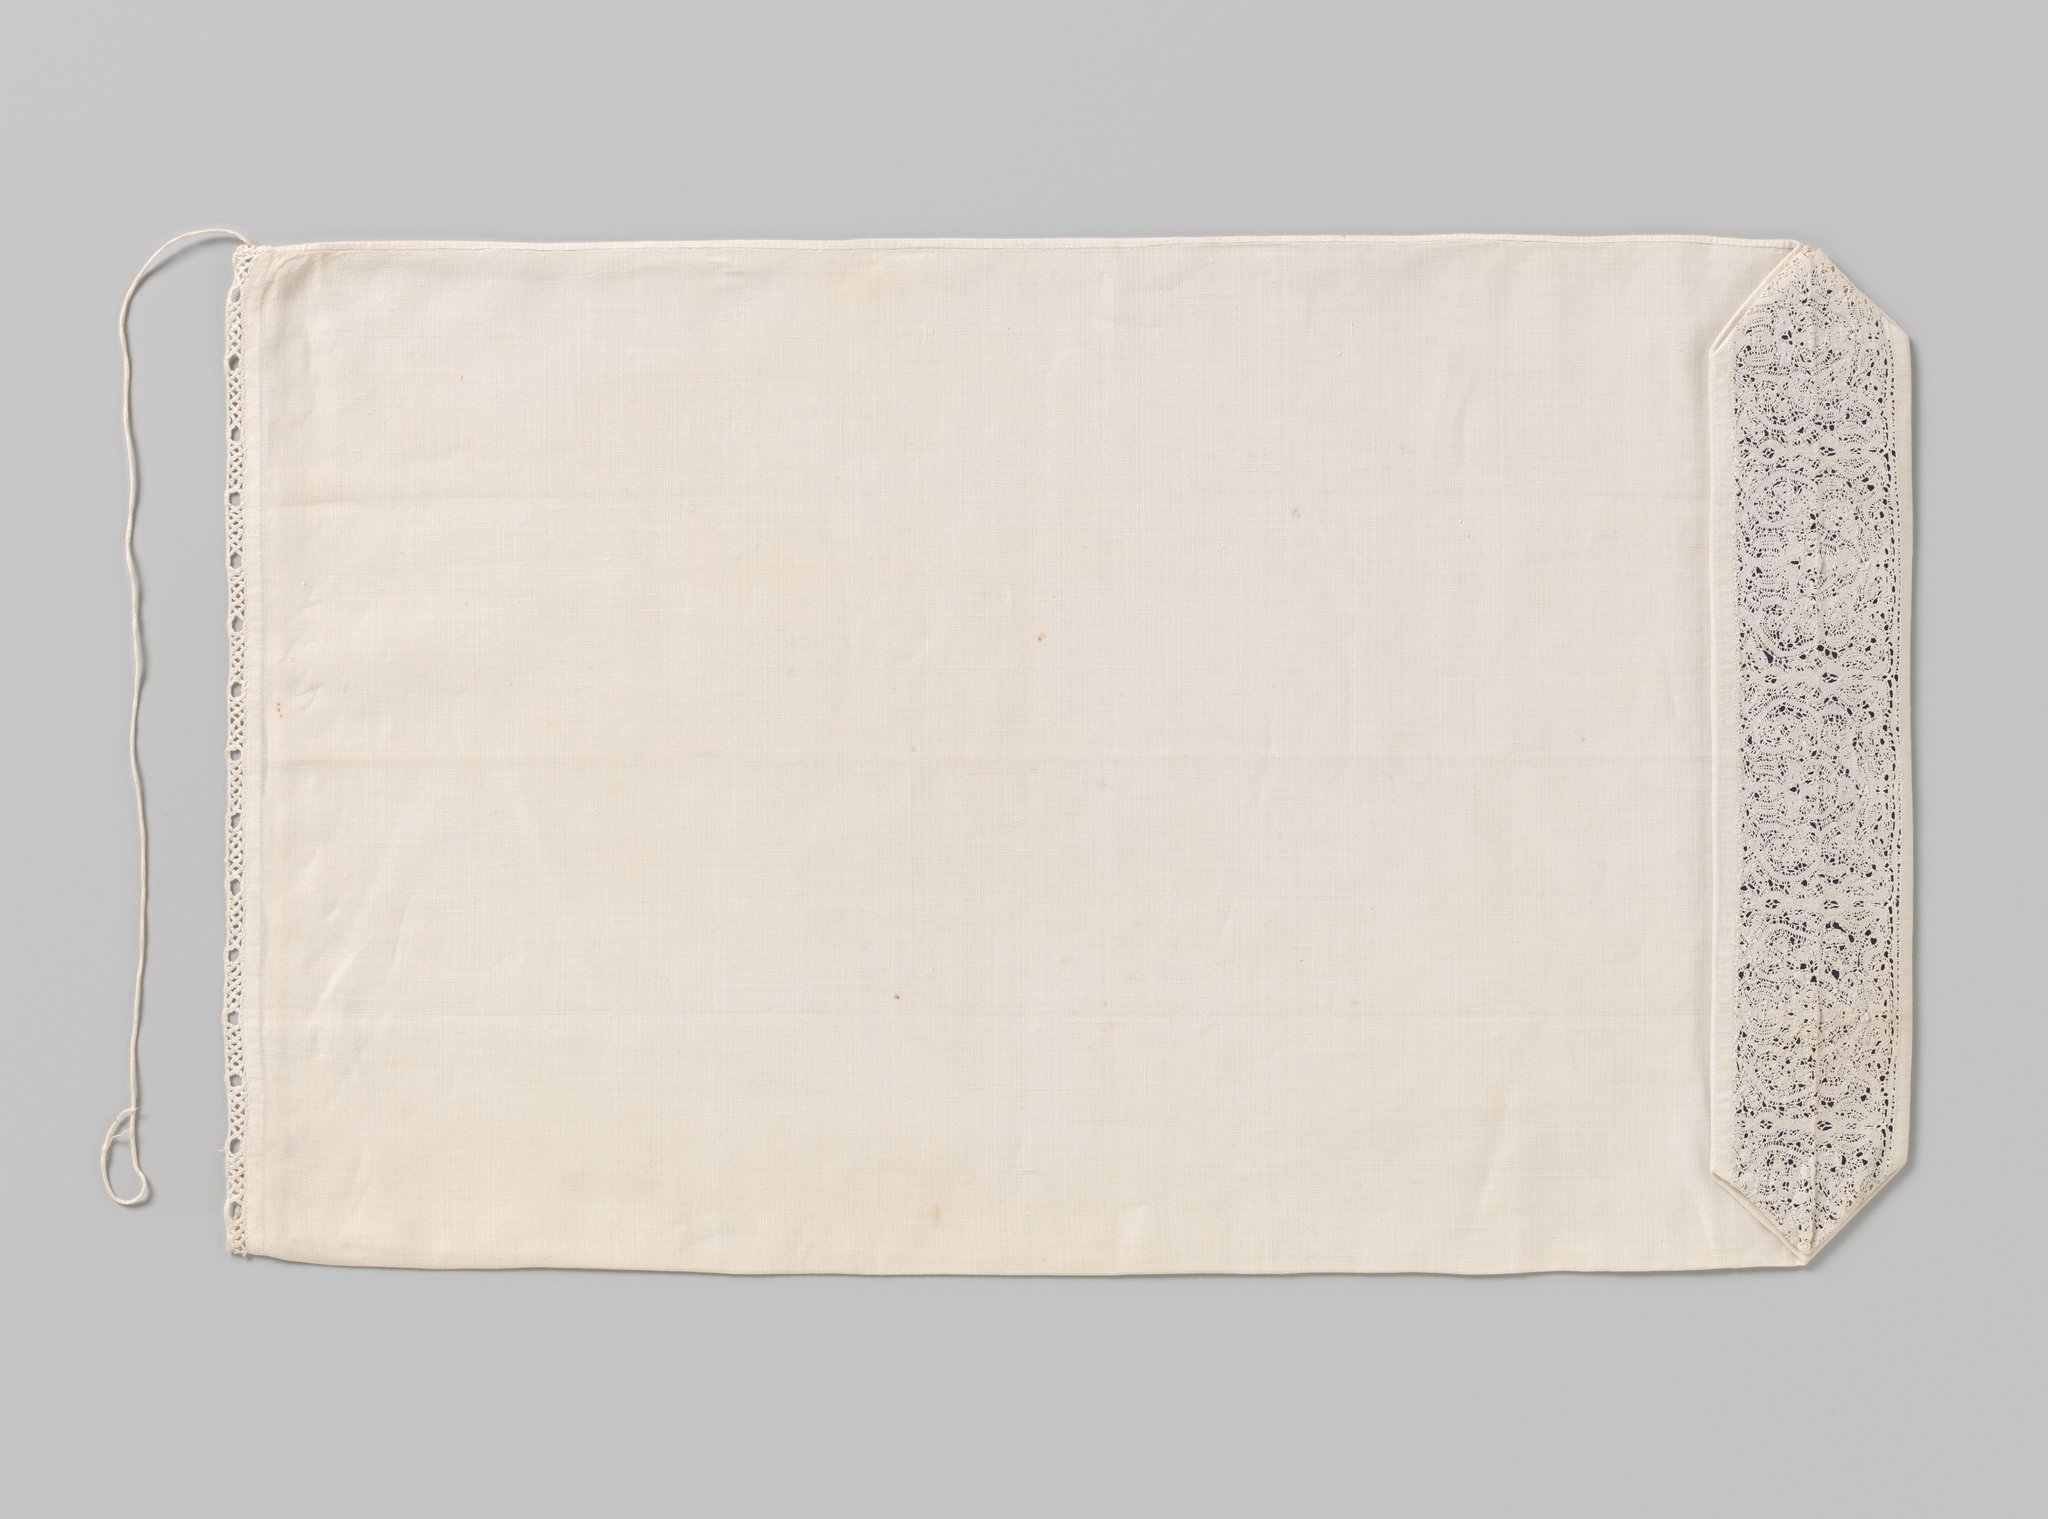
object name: lendensloop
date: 1650-1660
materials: linen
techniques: lace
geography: northern netherlands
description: Lendensloop van linnen met een entre-deux van kloskant. Aan het sluiteinde een geklost randje.